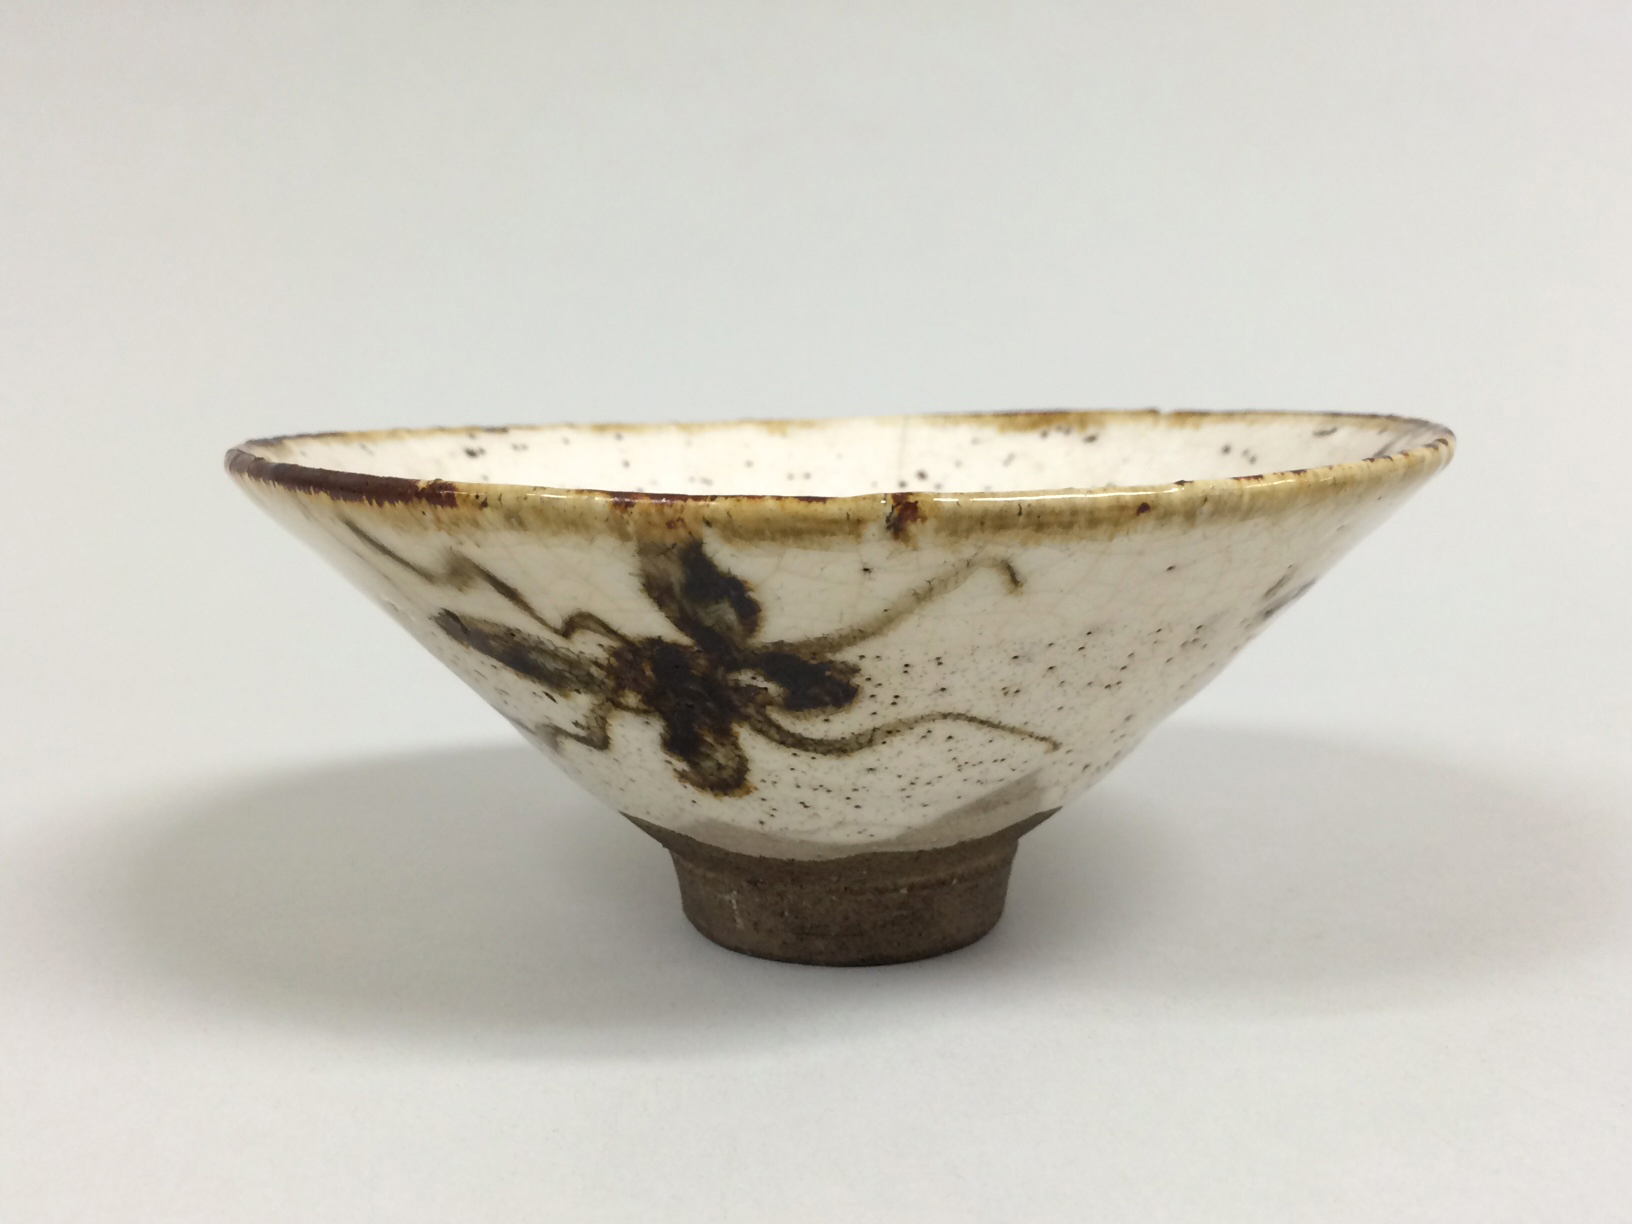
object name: teabowl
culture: japanese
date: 1701-1800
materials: clay, glaze